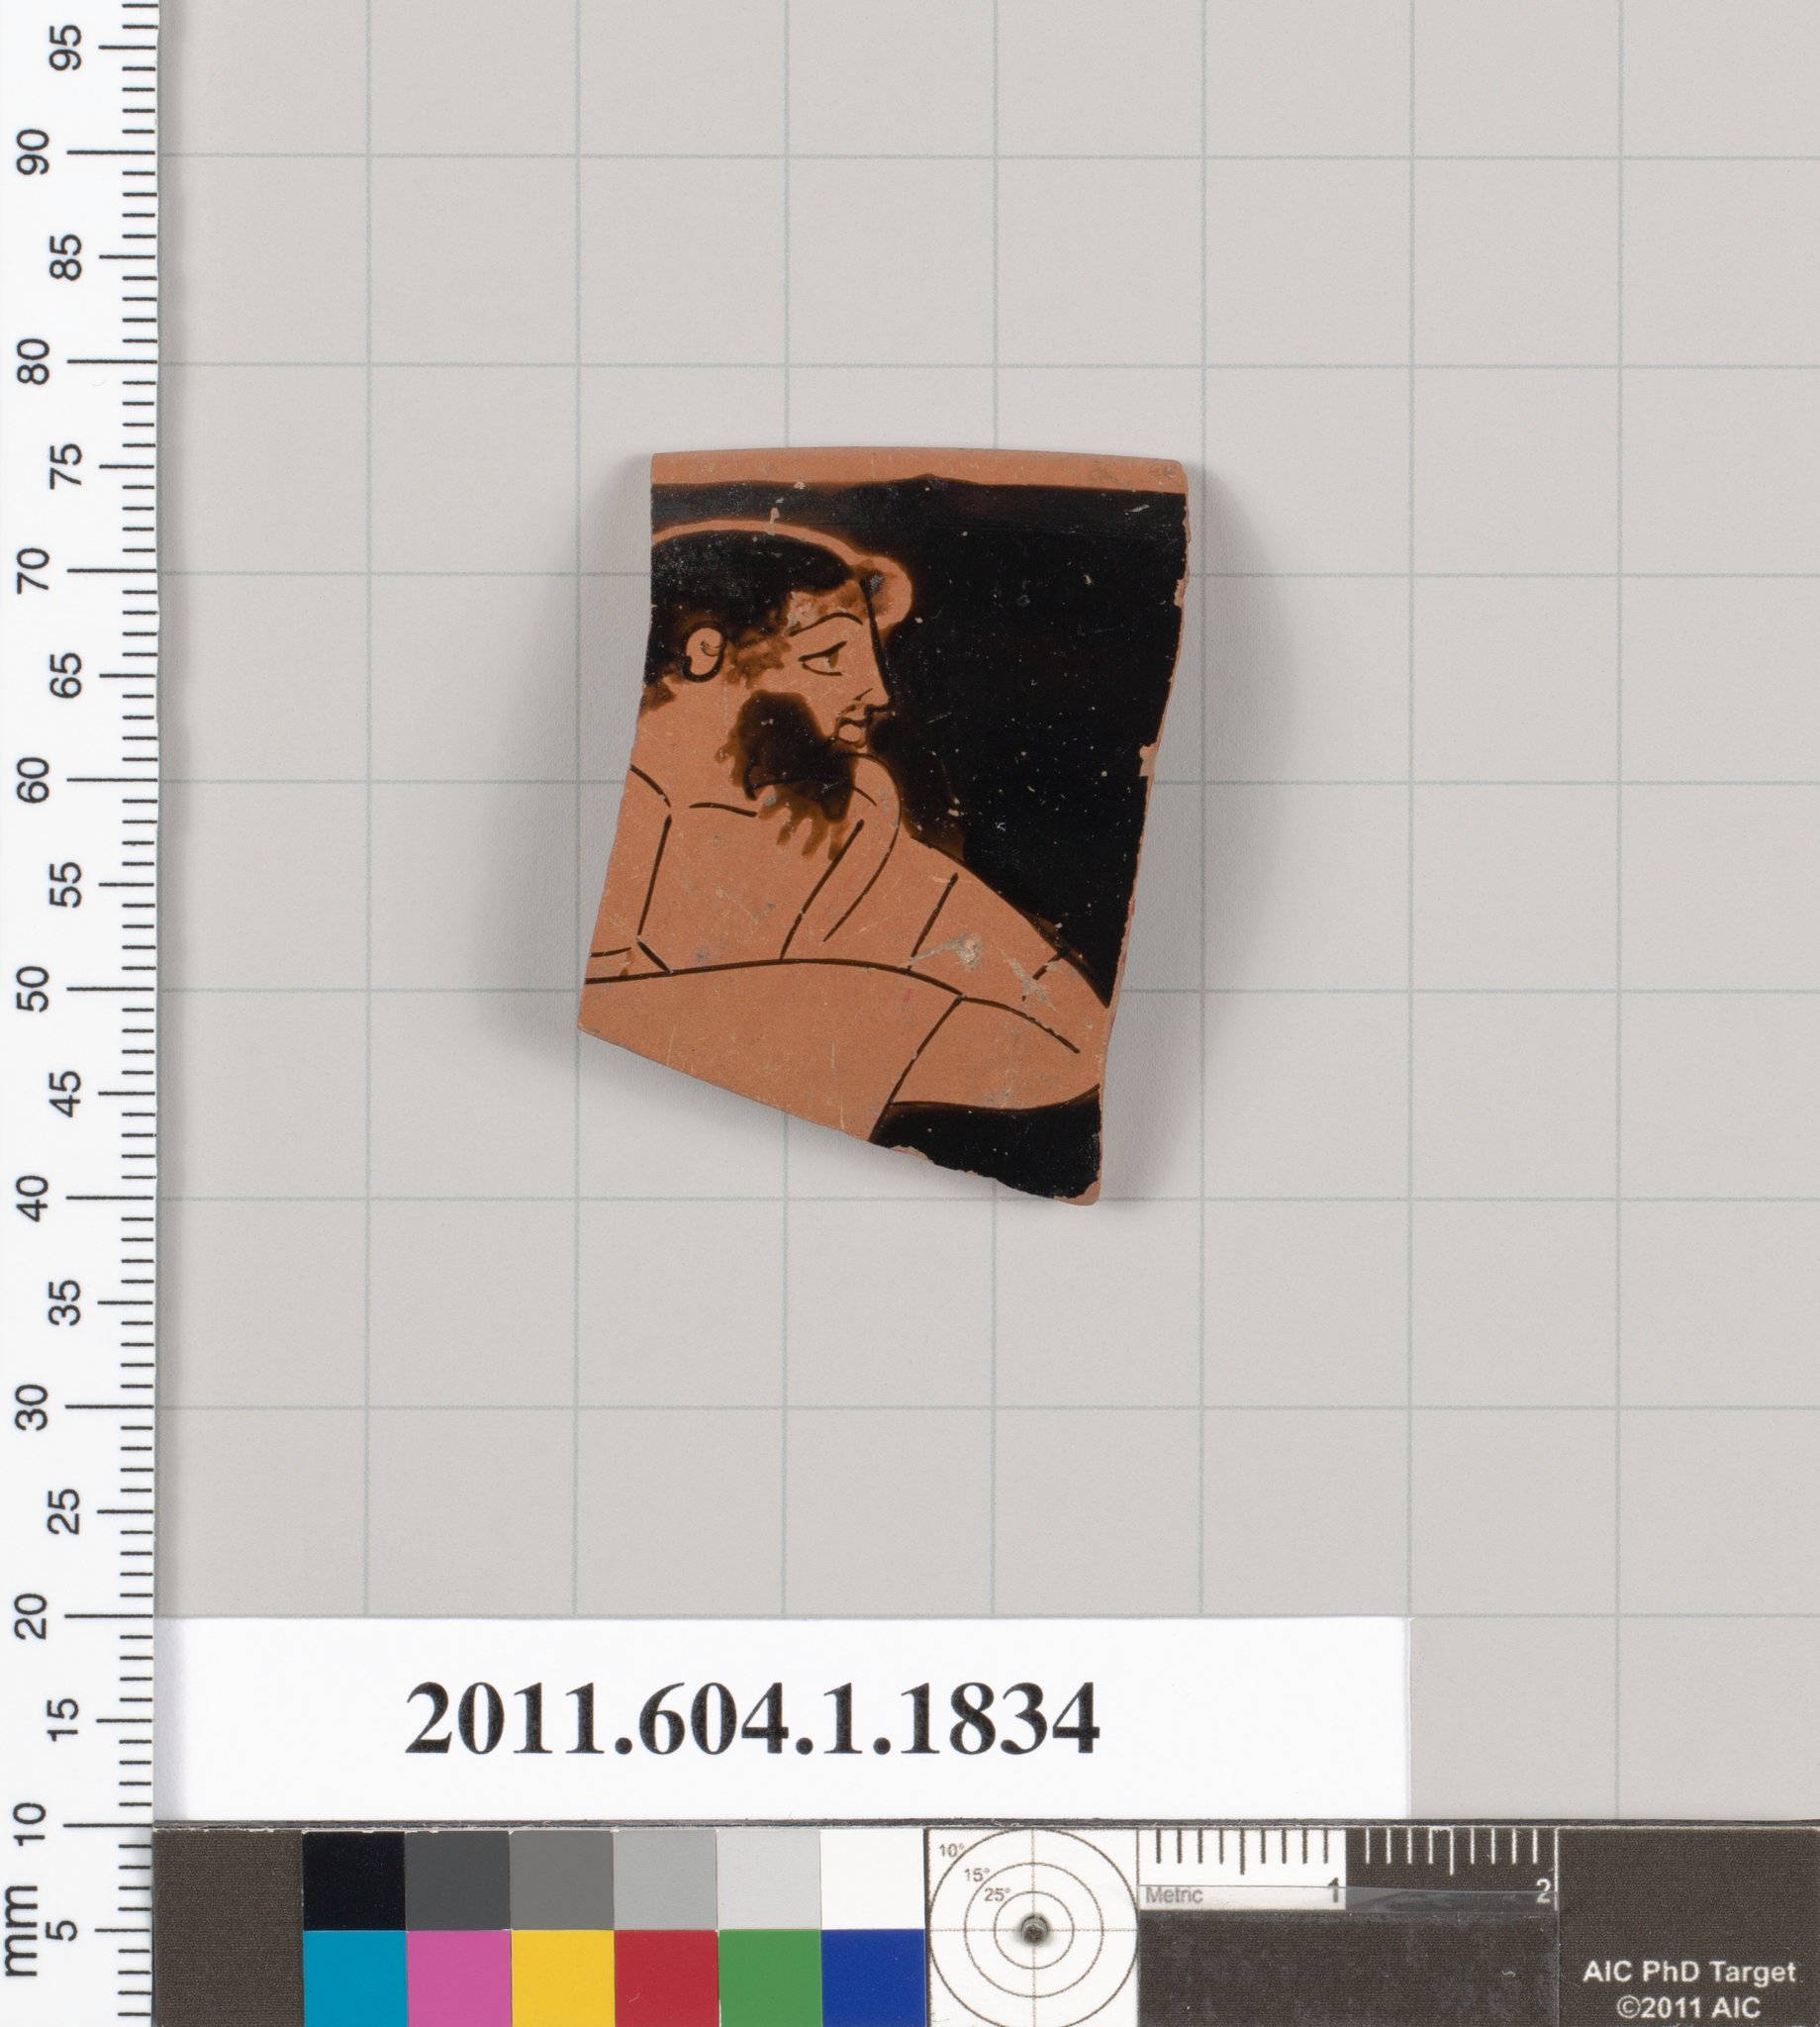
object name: kylix fragment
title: Terracotta rim fragment of a kylix (drinking cup)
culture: greek, attic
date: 475-451 BCE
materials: terracotta